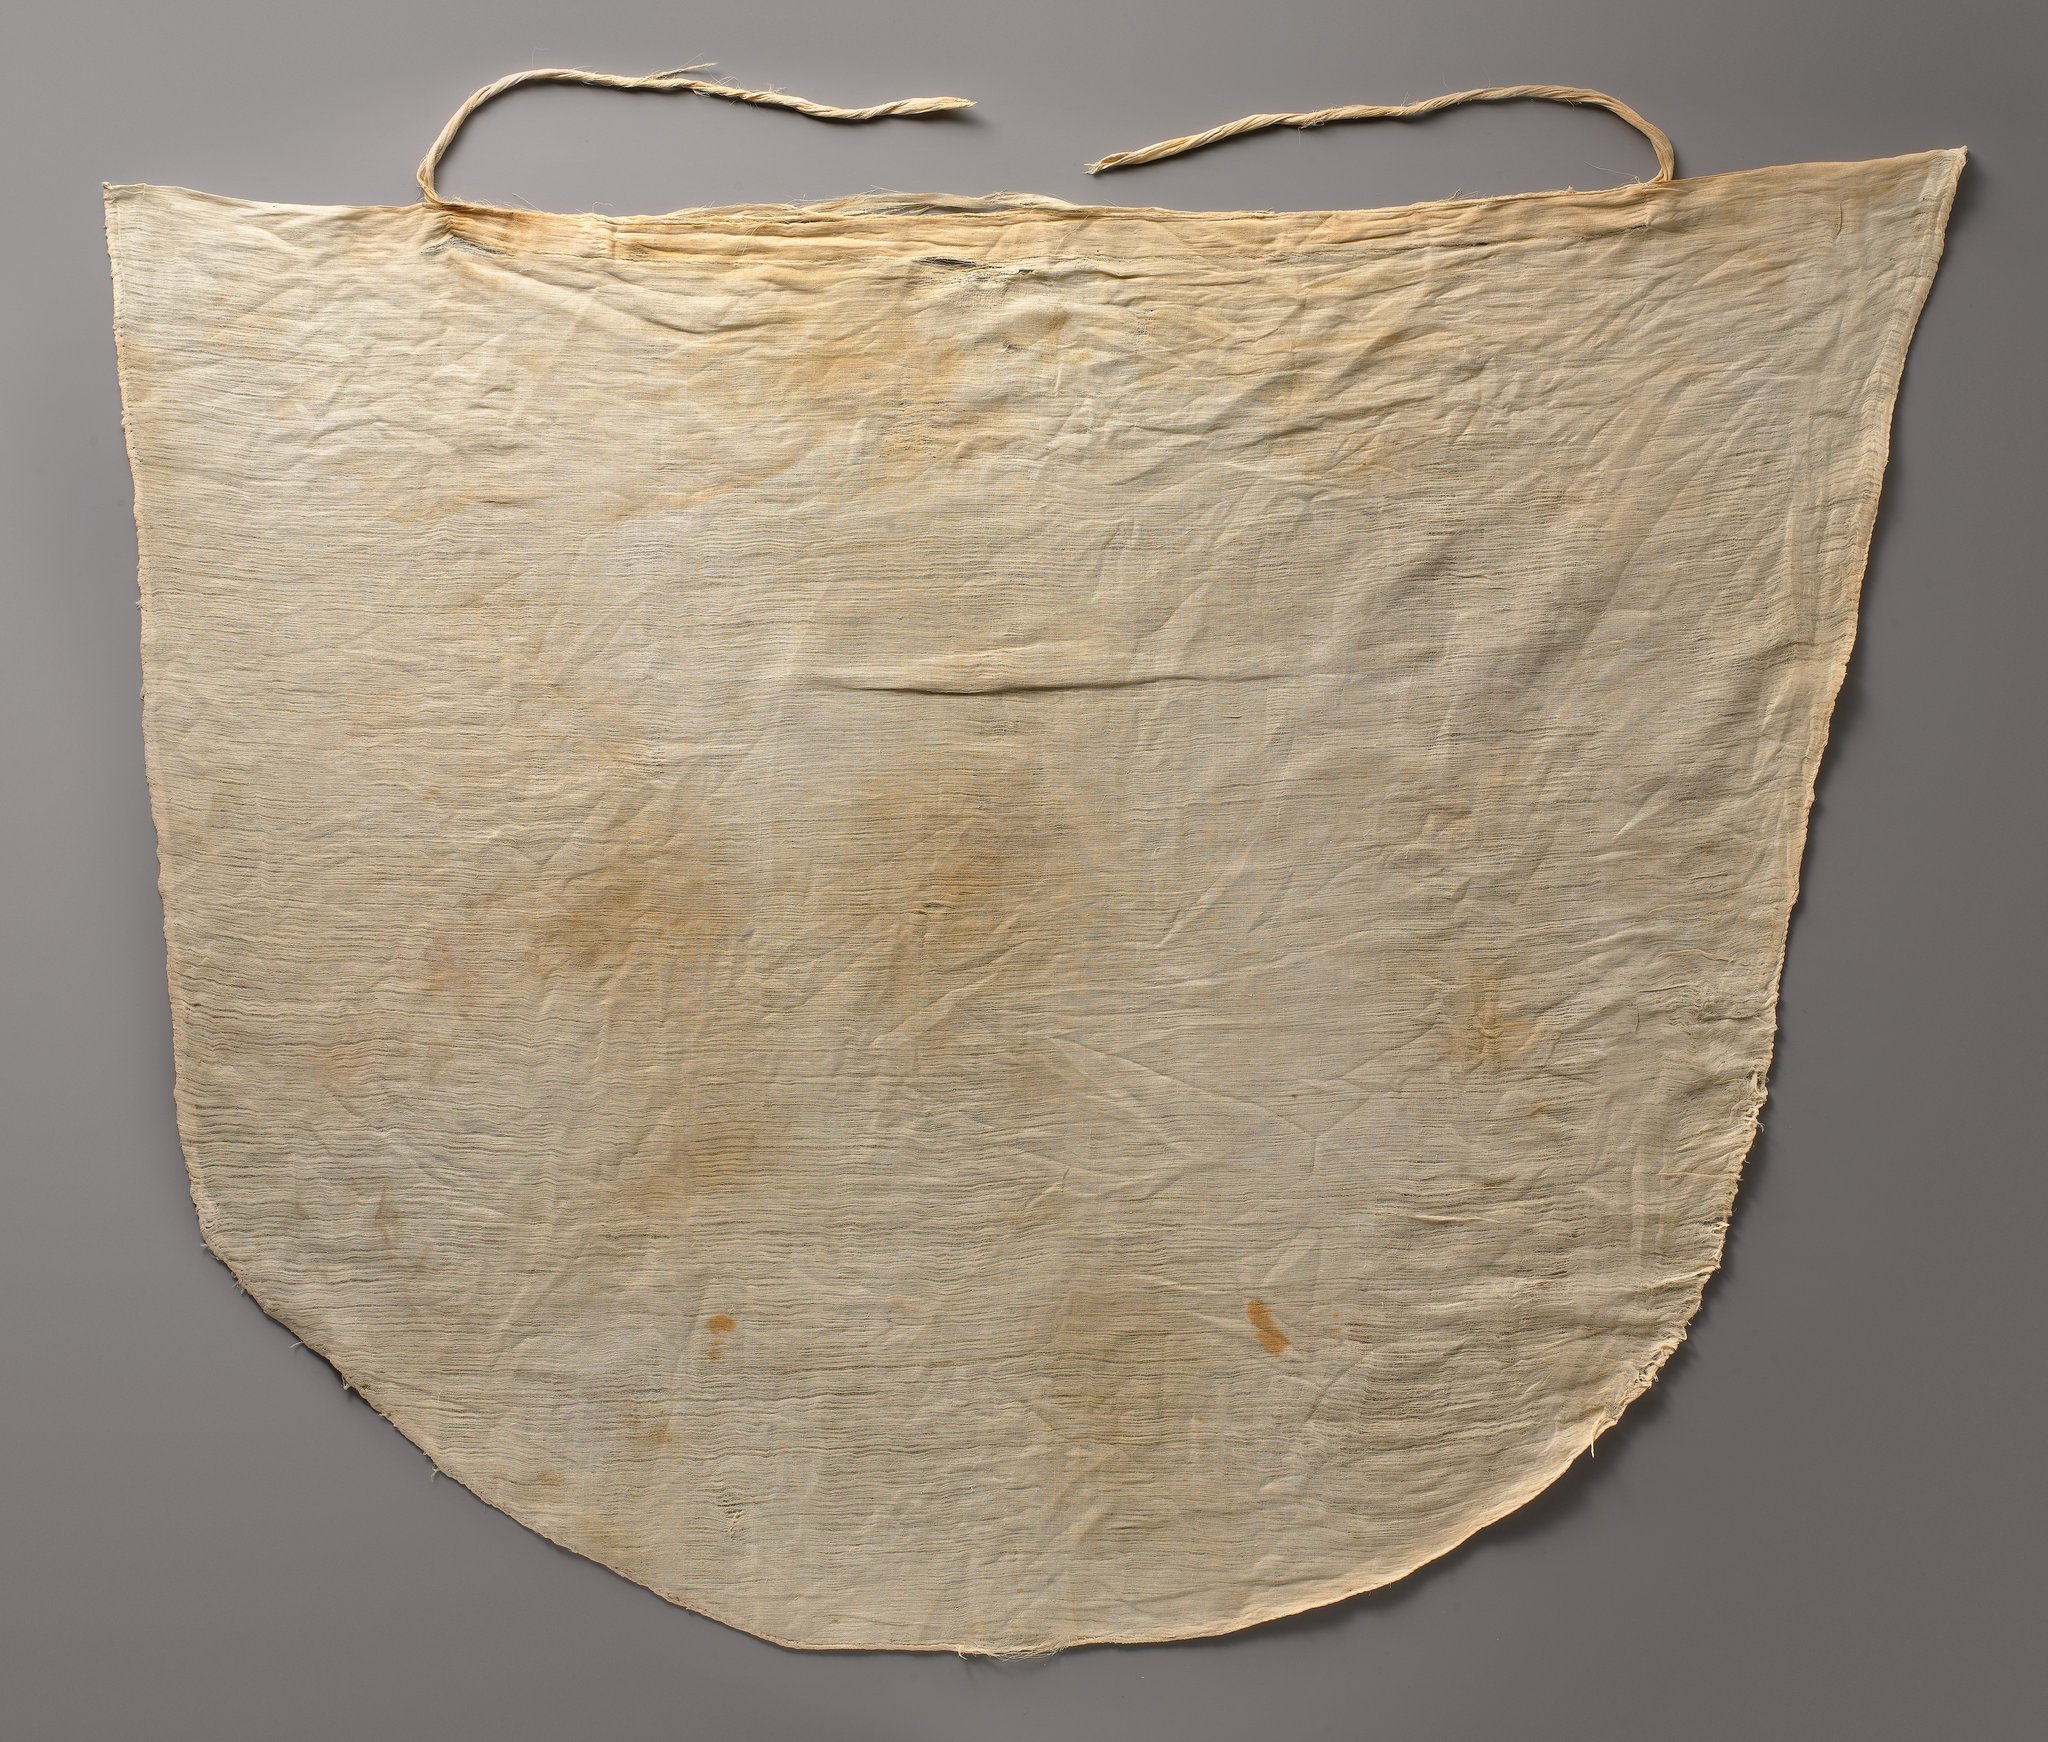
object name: kerchief, tutankhamun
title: Kerchief from Tutankhamun's Embalming Cache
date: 1336-1327 BCE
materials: linen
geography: egypt